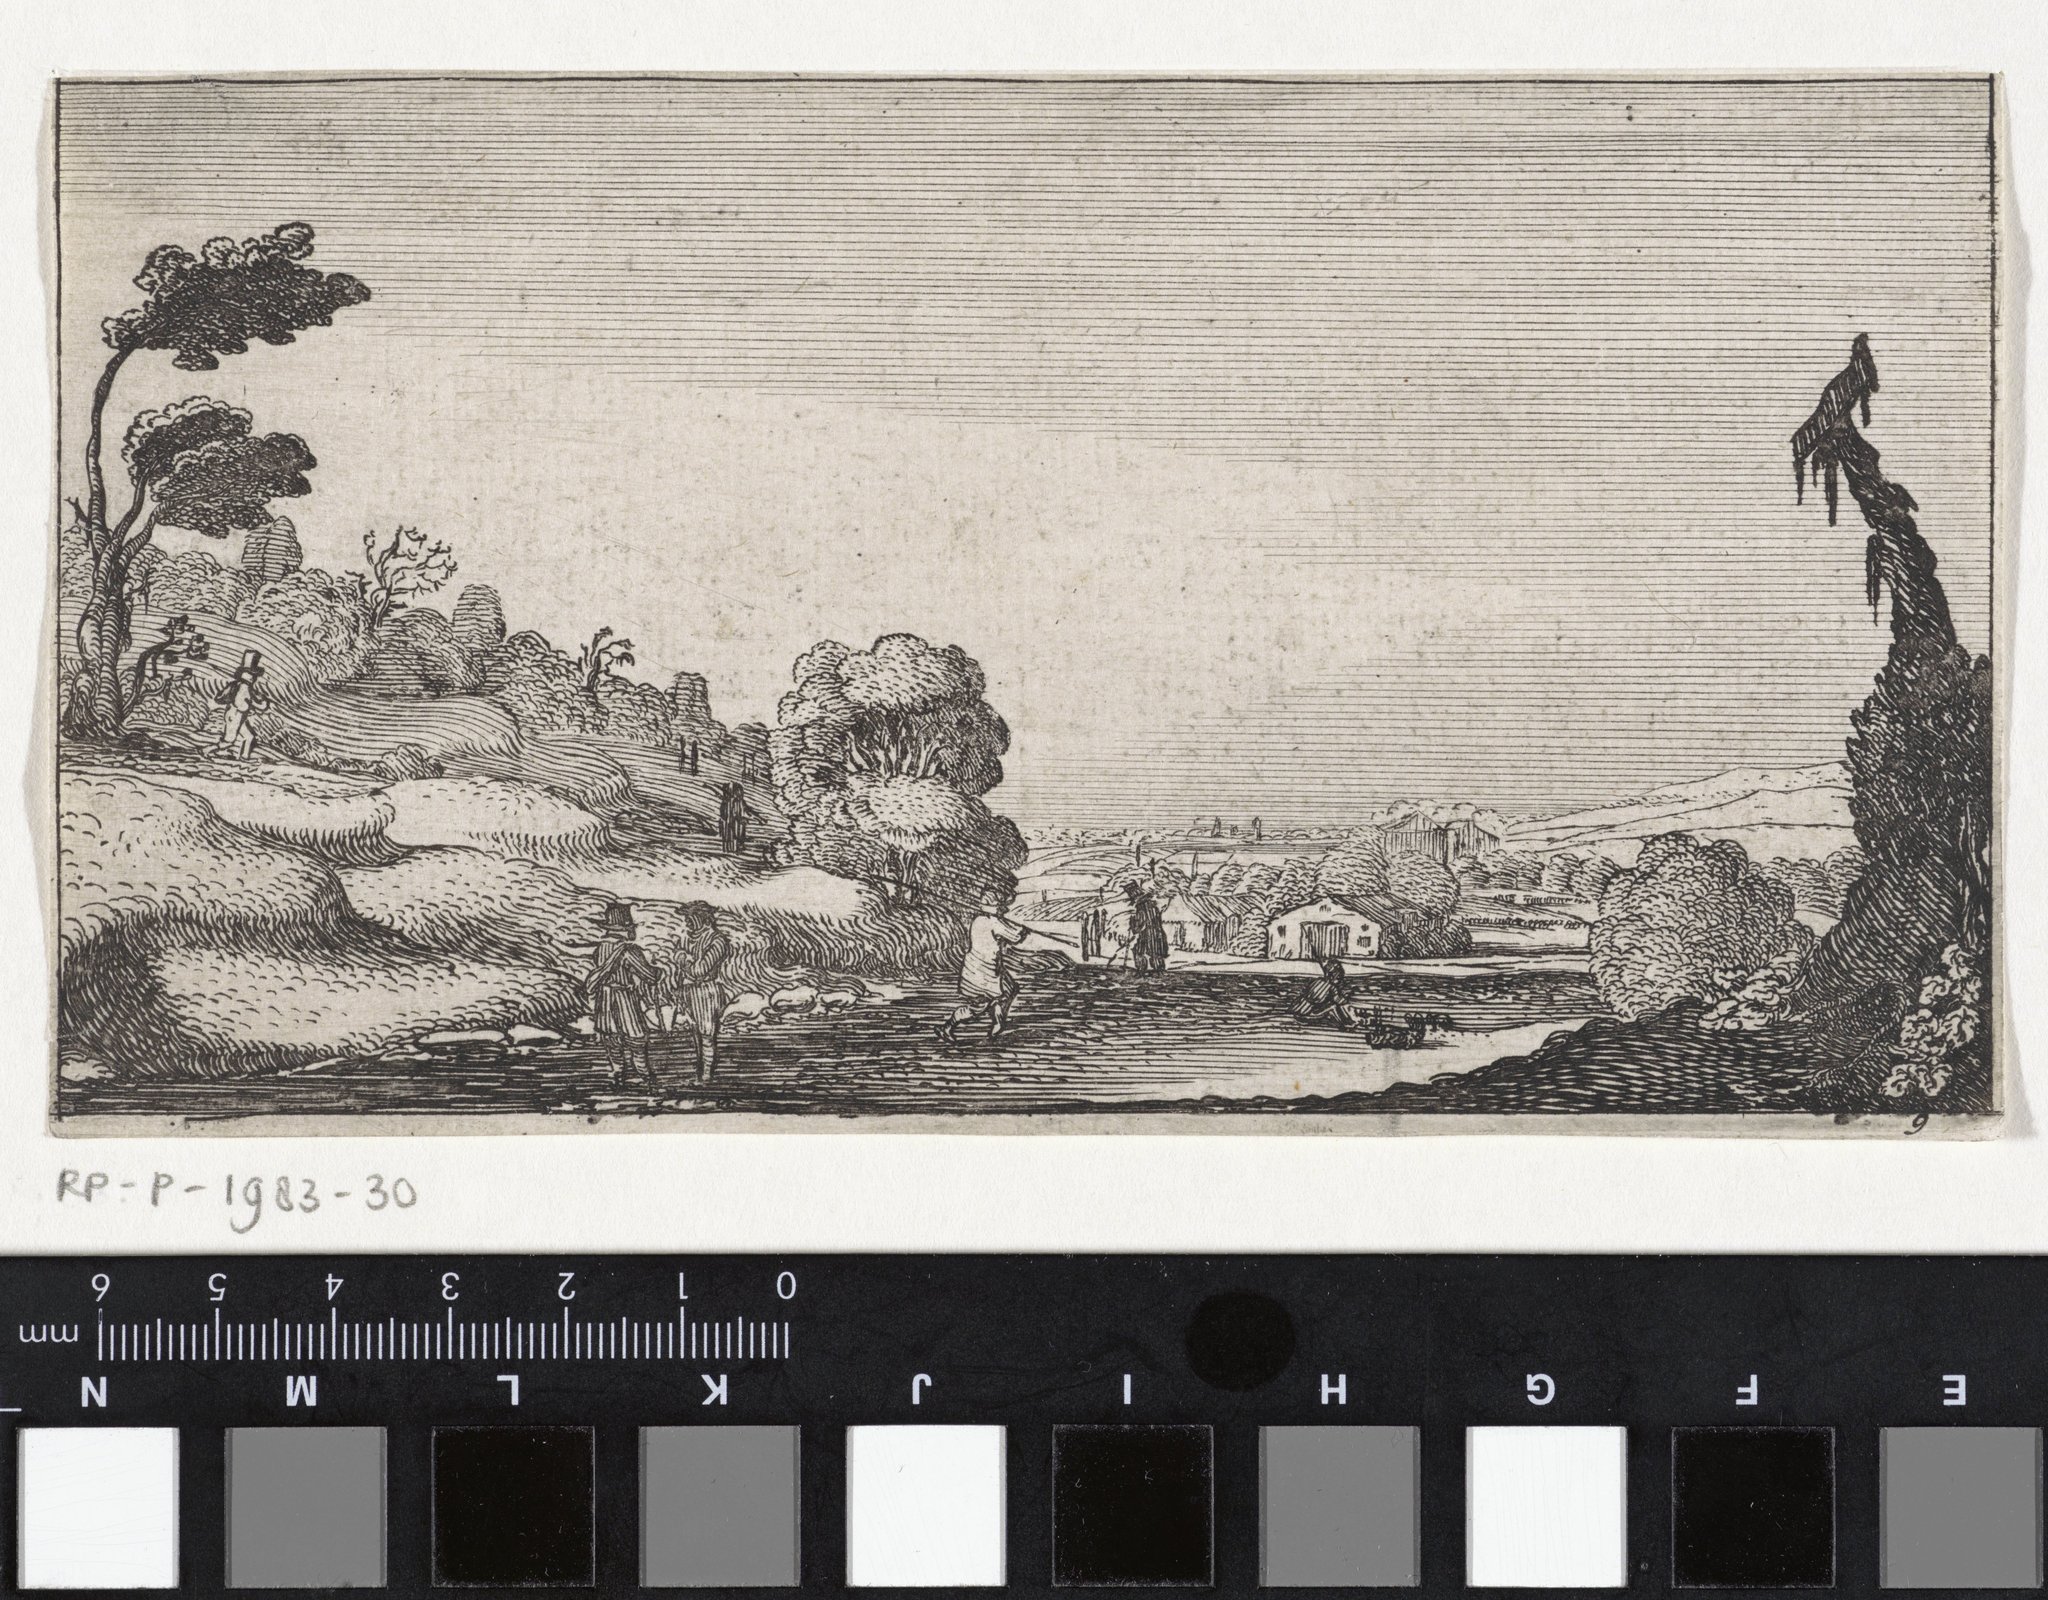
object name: print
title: Landschappen met figuren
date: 1624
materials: paper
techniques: etching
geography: northern netherlands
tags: herding, herdsman, herdswoman, shepherd, shepherdess, cowherd, etc., rural housing, e.g. country-house, villa, cottage, low hill country (+ landscape with figures, staffage)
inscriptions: collector's mark: Lugt 2760, collector's mark: Lugt 2228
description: Links enkele figuren op een heuvelpad. In het midden zit een herder bij zijn kudde. Op de achtergrond twee boerderijen.